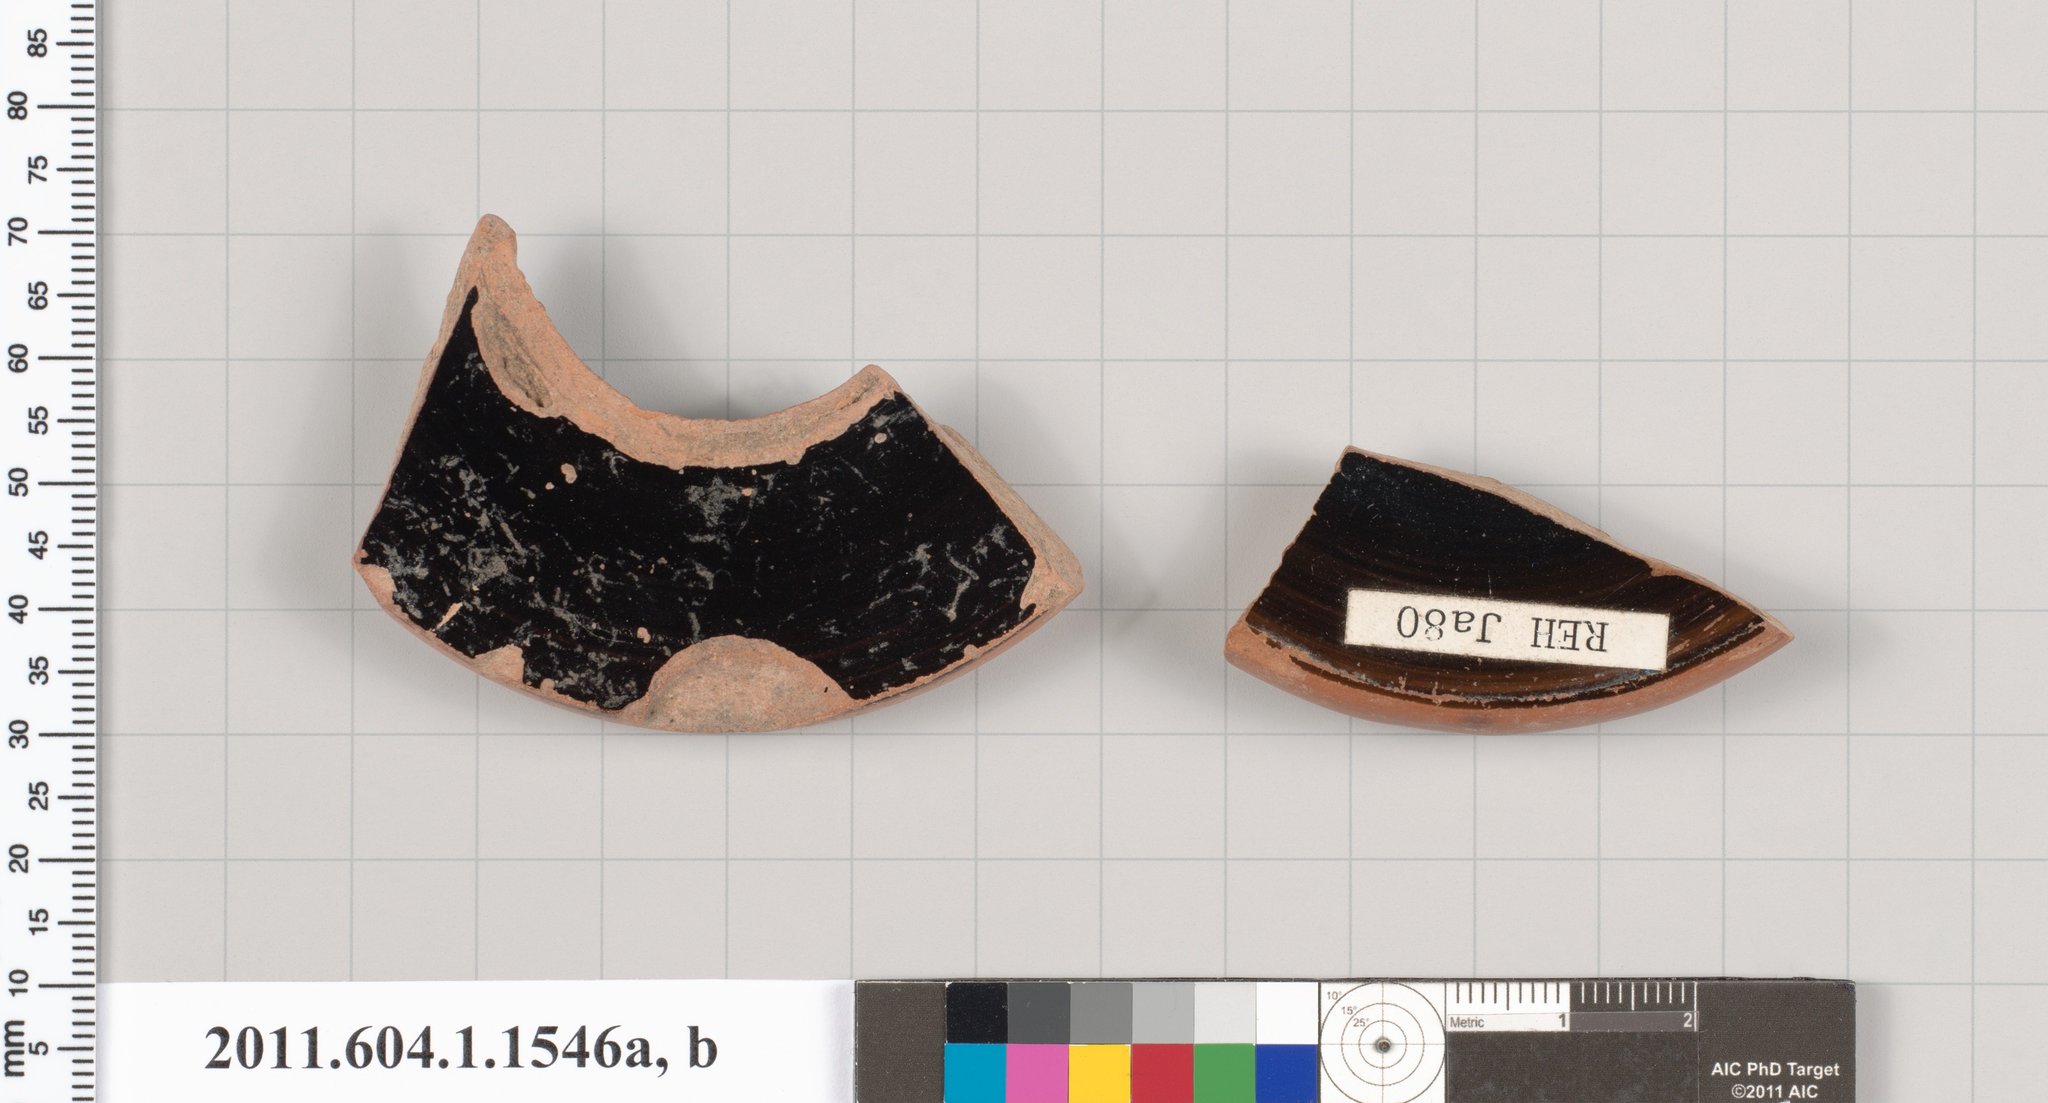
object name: kylix fragment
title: Terracotta fragments of kylikes (drinking cups)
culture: greek, attic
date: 500-401 BCE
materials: terracotta